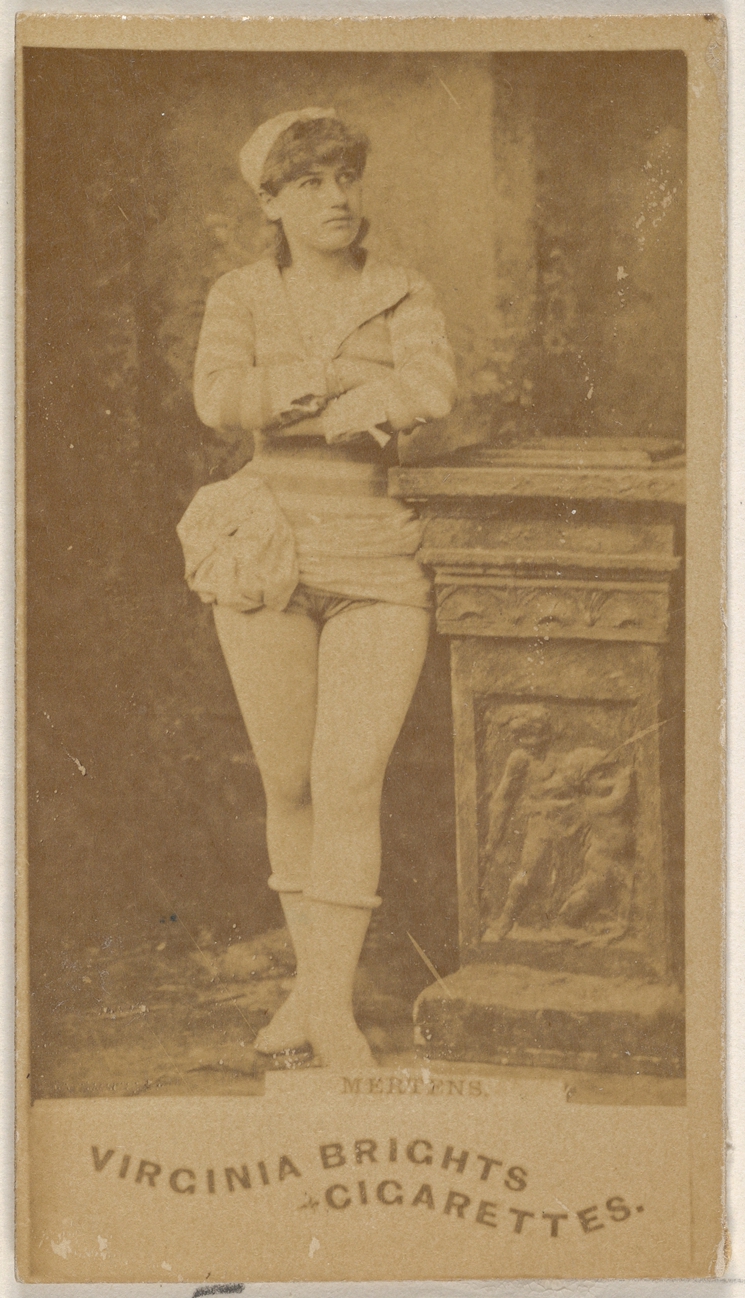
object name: photograph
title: Mertens, from the Actors and Actresses series (N45, Type 1) for Virginia Brights Cigarettes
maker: allen & ginter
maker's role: publisher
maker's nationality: american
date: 1888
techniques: albumen silver print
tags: portraits,women,actresses